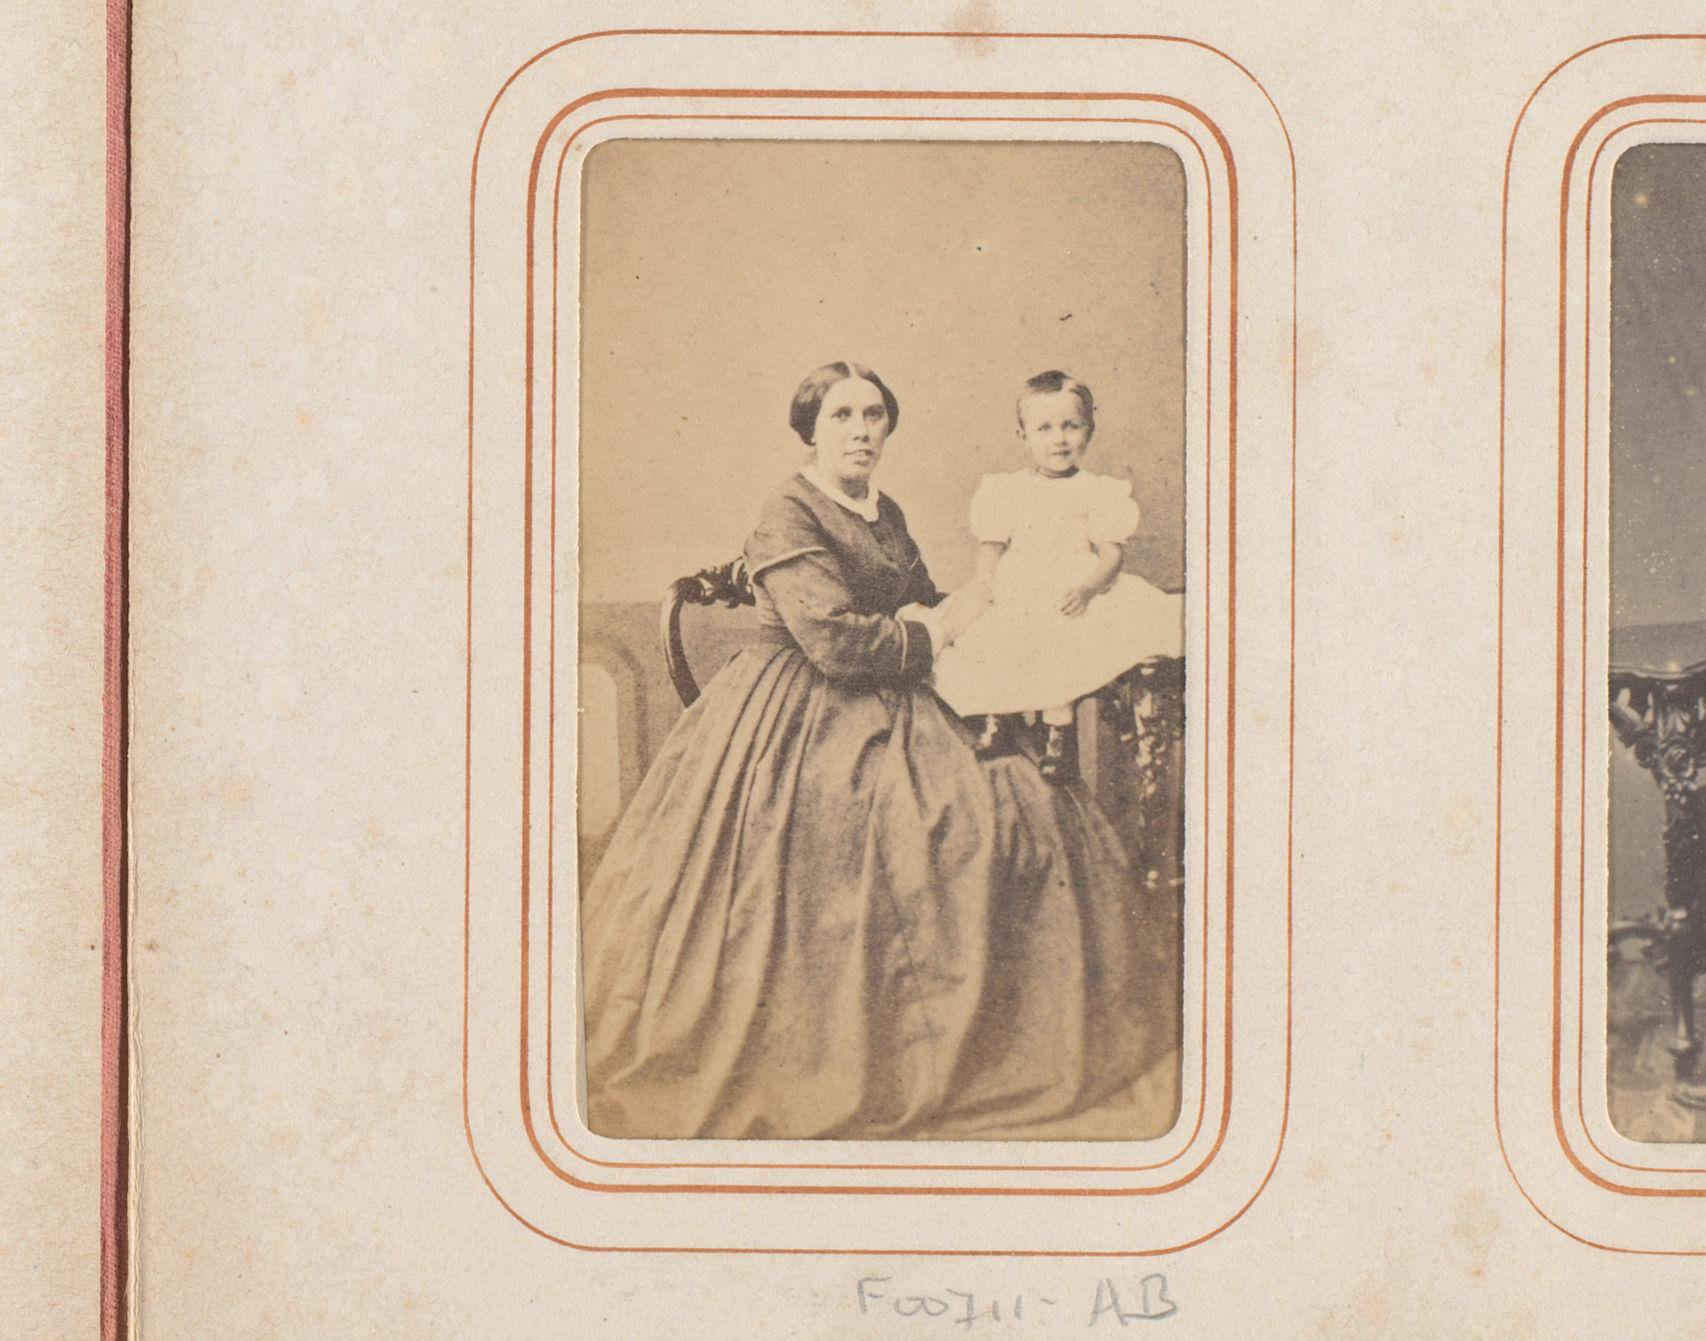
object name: photograph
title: Portret van een vrouw met kind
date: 1850-1874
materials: cardboard, photographic support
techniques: albumen print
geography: europe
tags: mother and child(ren), woman and child(ren) (family group)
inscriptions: inscription: ‘The London/ and Continental/ Photographic/ copying company’